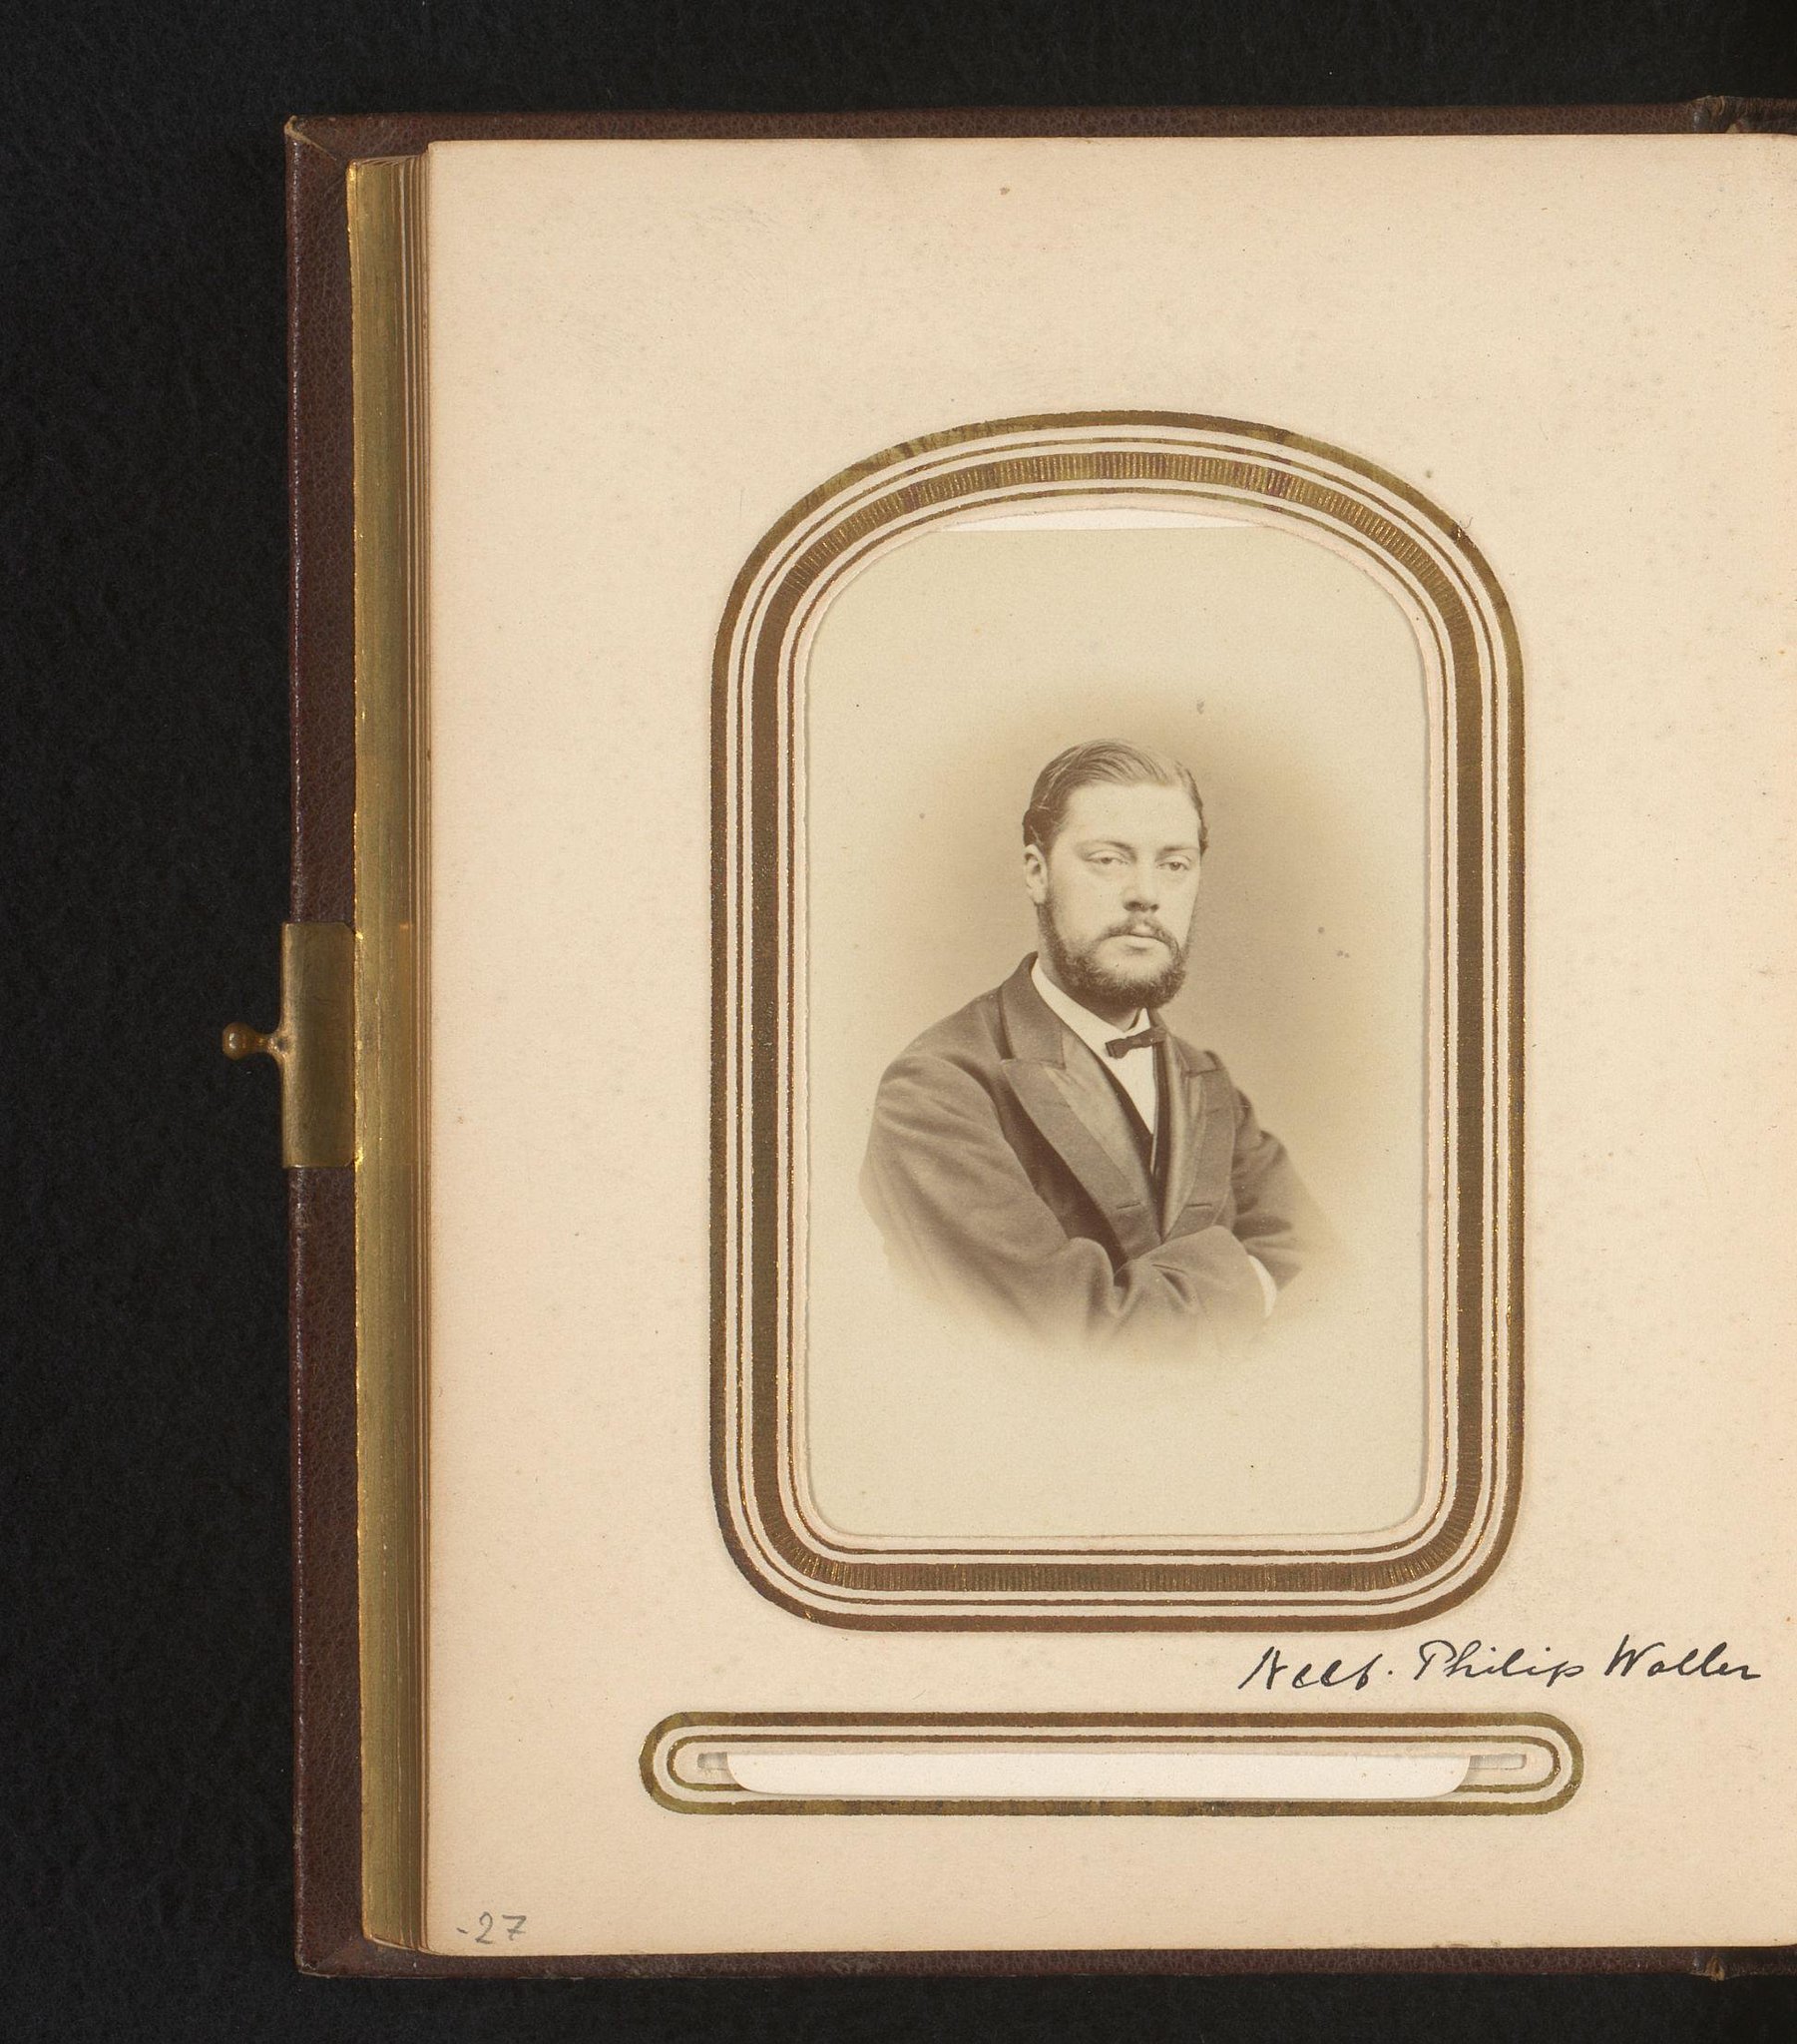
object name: album leaf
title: Portret van Philip Waller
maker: albert greiner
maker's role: fotograaf, fotostudio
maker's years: 1833-1890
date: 1861-1874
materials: cardboard, paper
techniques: albumen print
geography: amsterdam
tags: historical persons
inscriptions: address: ‘NIEUWENDIJK. L. 87/ AMSTERDAM’